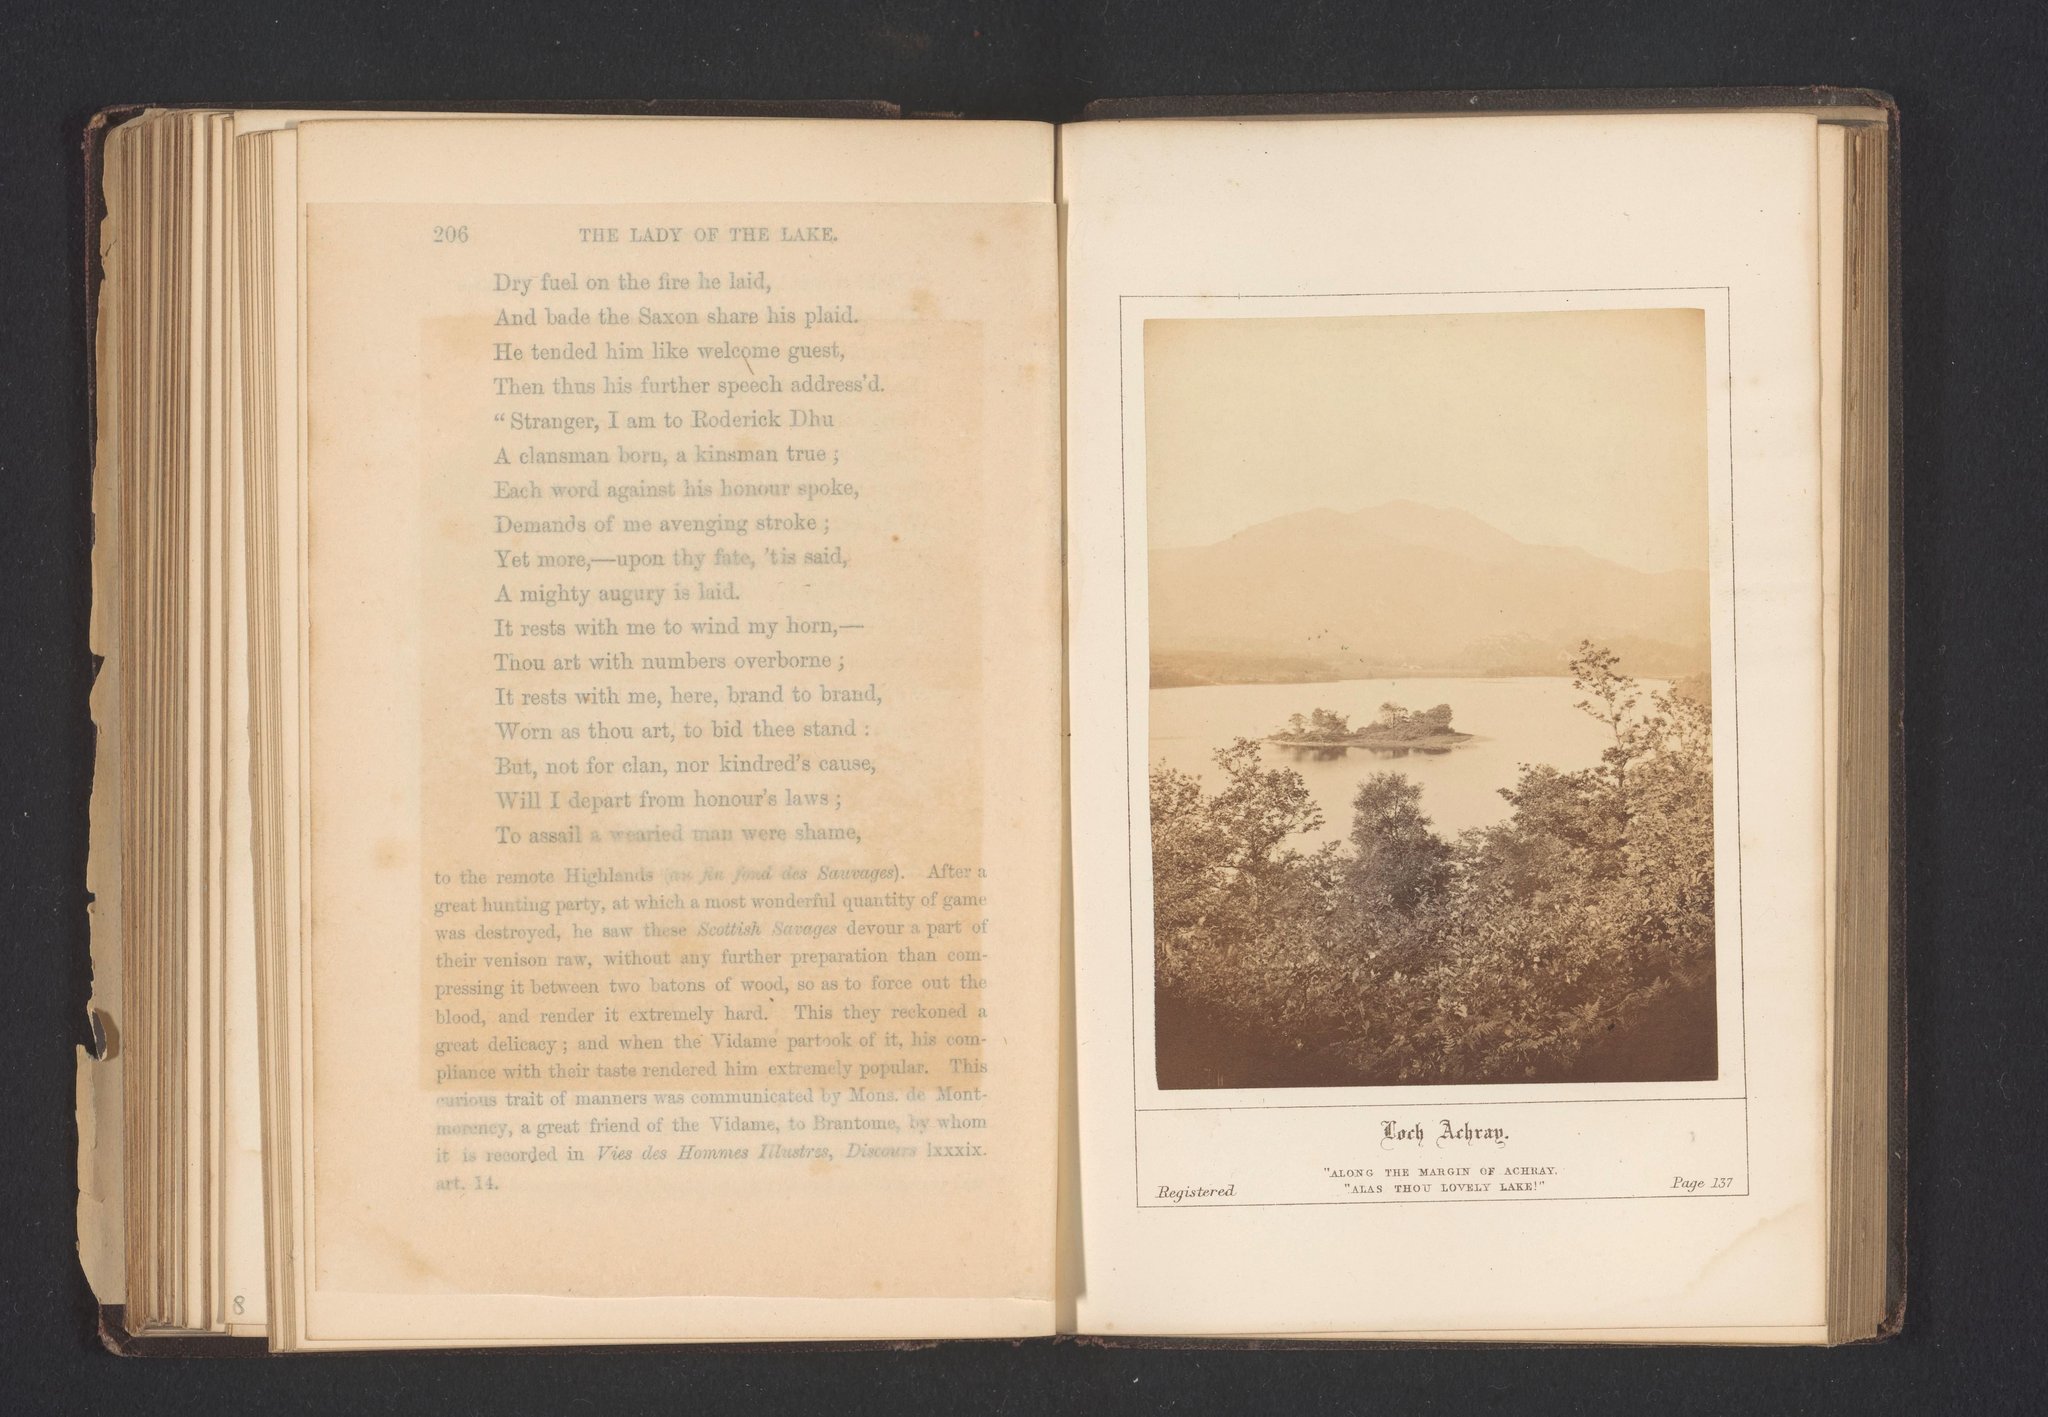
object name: page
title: Gezicht op Loch Achray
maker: george washington wilson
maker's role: publisher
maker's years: 1823-1893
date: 1855-1865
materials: photographic support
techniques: albumen print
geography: loch achray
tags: lake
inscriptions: number: ‘Page 137.’, inscription: ‘“Along the margin of Achray,“Alas thou lovely lake.”’